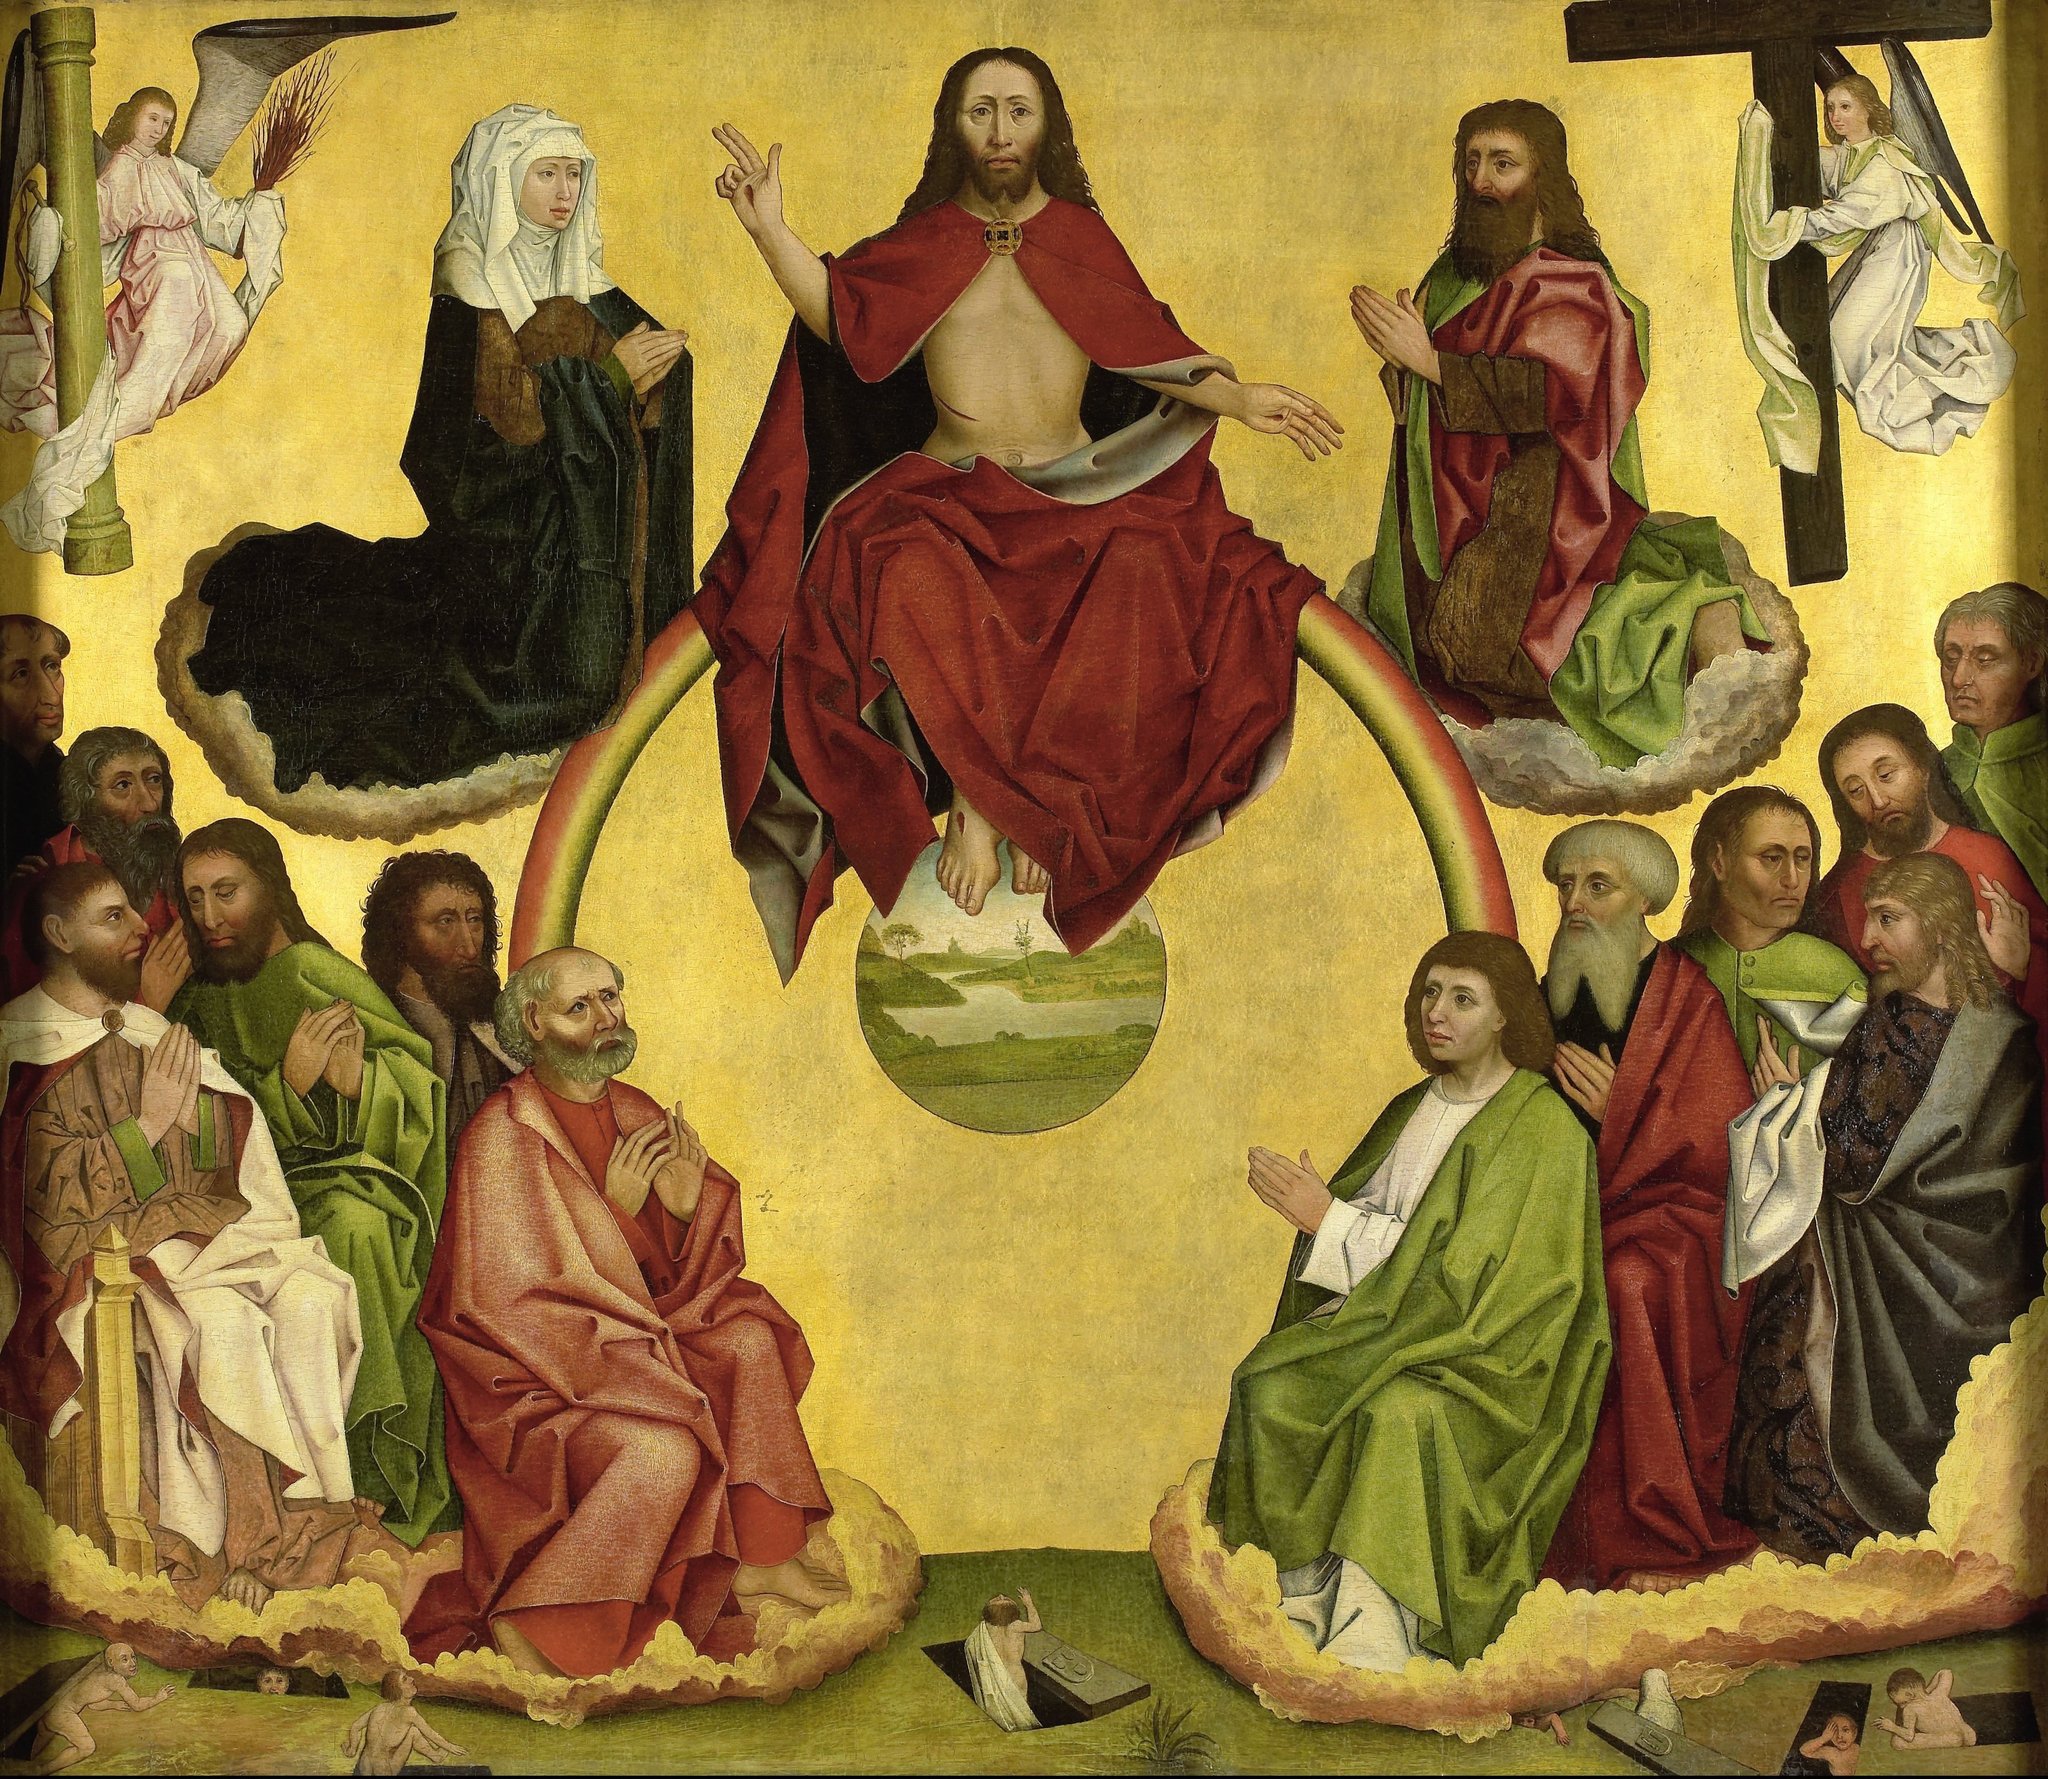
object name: painting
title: Last Judgment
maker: Anonymous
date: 1500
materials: oil, panel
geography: westphalia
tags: comprehensive representation of last judgement: christ (with sword and lily), often surrounded by elders and sometimes accompanied by mary and john the baptist, appears in the sky with trumpeting angels (and sometimes angels holding the instruments of the passion); after the resurrection of the dead the blessed are led to heaven by angels, and the damned are dragged into hell by devils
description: Het laatste oordeel. Christus zittend op de regenboog met links Maria en rechts Johannes de Doper. In de hemel engelen met de passiewerktuigen. Lager zitten de discipelen op wolken, boven de aarde waar de doden uit hun graven opstaan.